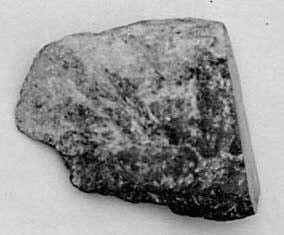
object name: fragment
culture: burmese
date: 1902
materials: jade